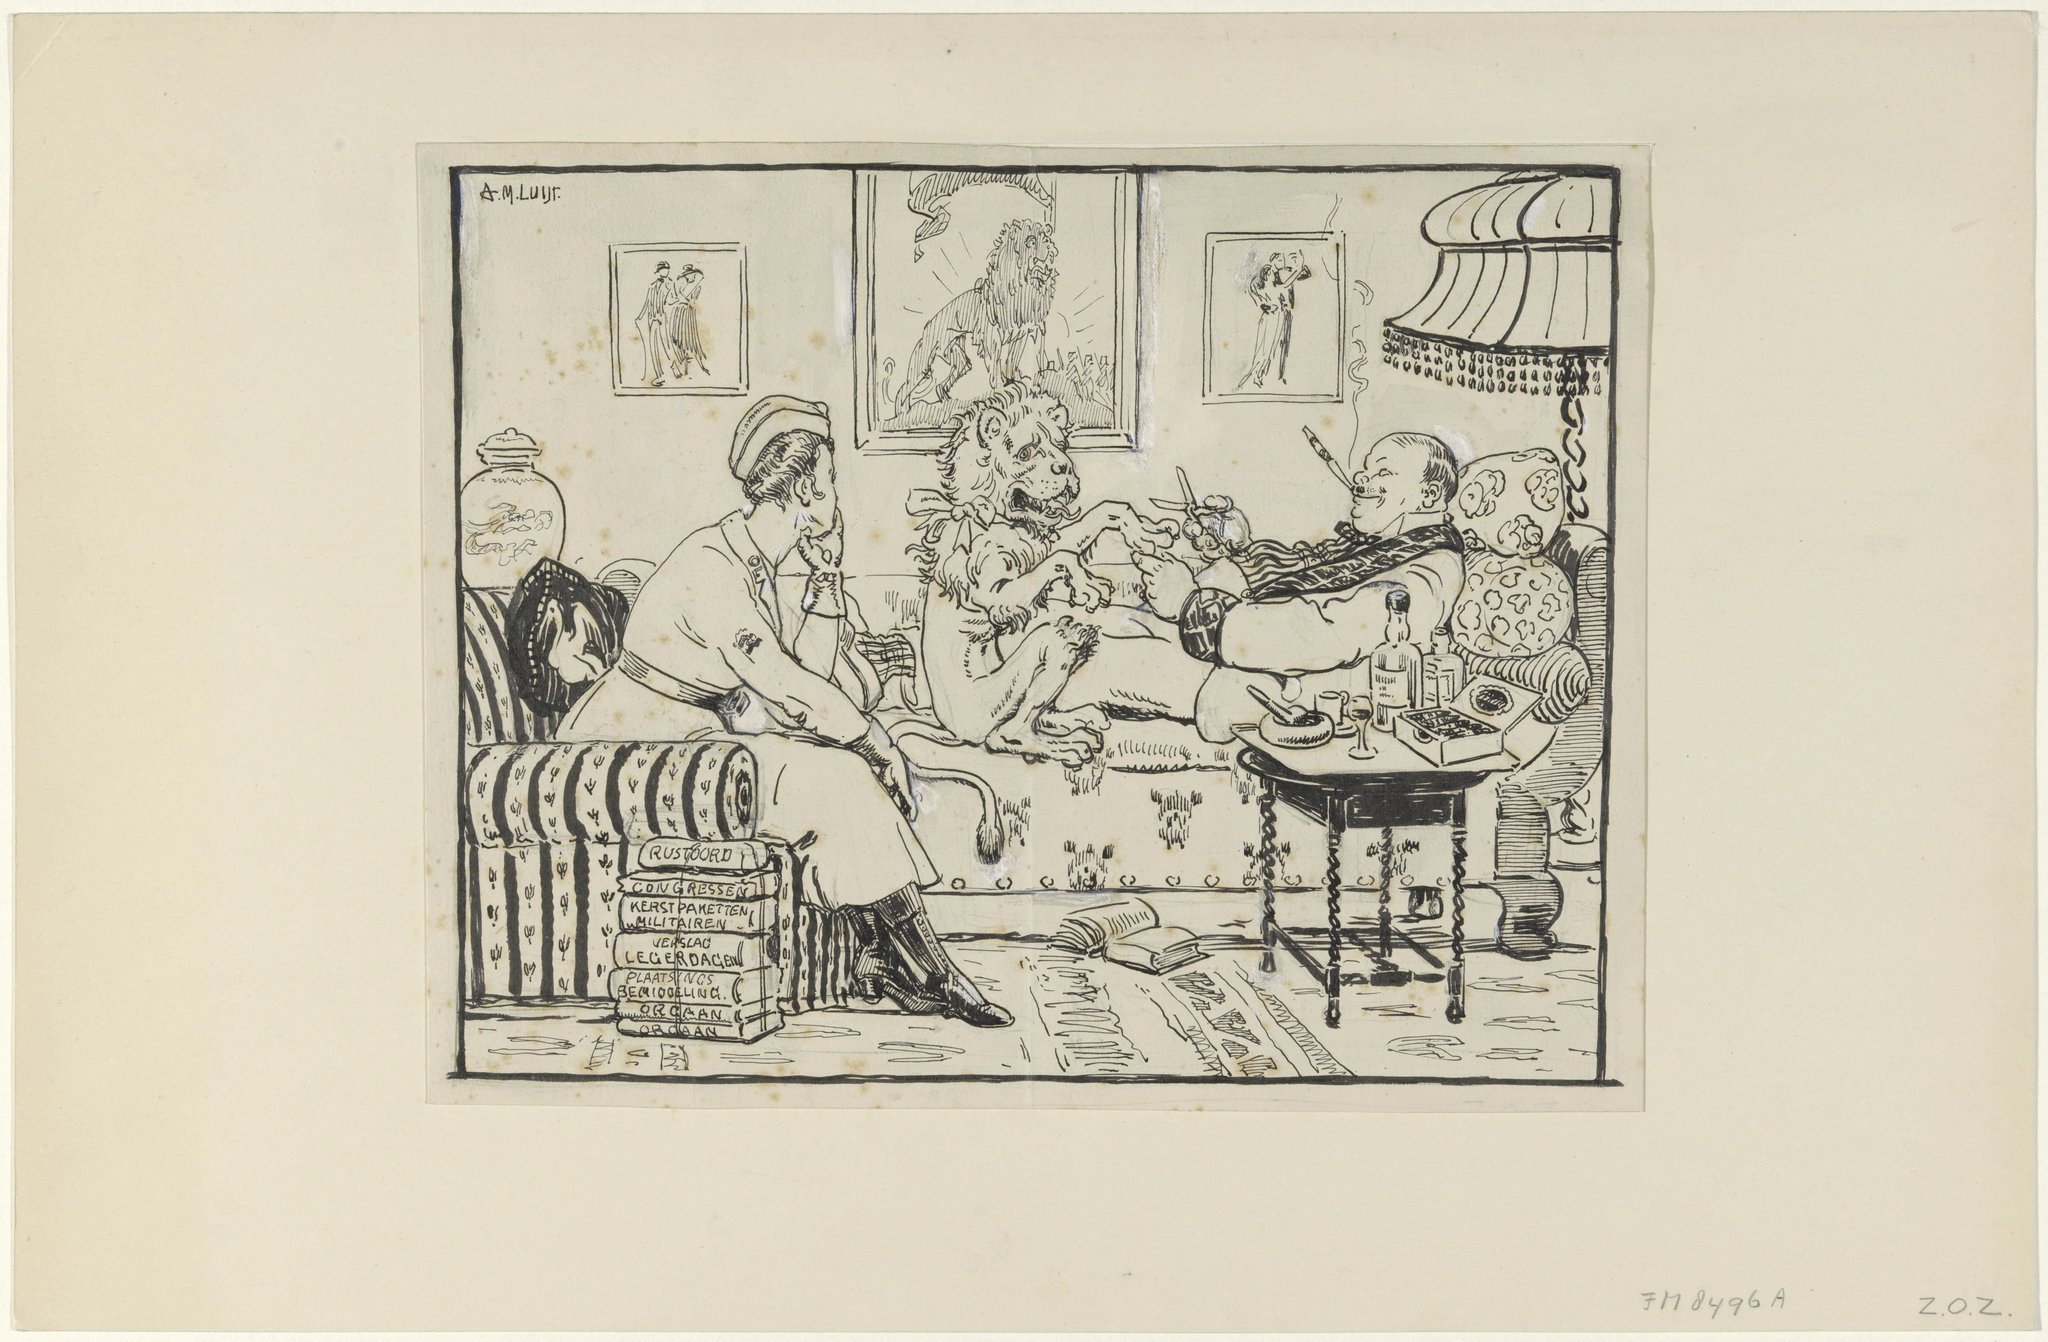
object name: drawing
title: Spotprent op het Nederlandse leger, 1917-1918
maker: arie martinus luijt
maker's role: print maker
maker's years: 1879-1951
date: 1917-1918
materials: paint, ink, paper, pencil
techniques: brush, pen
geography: netherlands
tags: beasts of prey, predatory animals: lion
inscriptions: inscription: ‘Leo, aardig krullenkopje, / Zit "is" op, geef eens een pootje; / Brul nou eens "miauw" / Och, hebben ze je nageltjes / afgeknipt?! / 1917/18 / Weekbl. v. R'dam / (of: "Ons Leger"?)’, collector's mark: ‘Bureau v.d. Rijksinspecteur voor Roerende Monumenten’, collector's mark: Lugt 2228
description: Spotprent op het Nederlandse leger, 1917-1918. In een huiskamer worden de nagels geknipt van de op een bank zittende en ongelukkig kijkende getemde Nederlandse Leeuw door een burger met een sigaar in de mond. Links kijkt een militair toe. Op de vloer een bundel boeken. Op de achterzijde van de tekening een opschrift van de tekenaar.